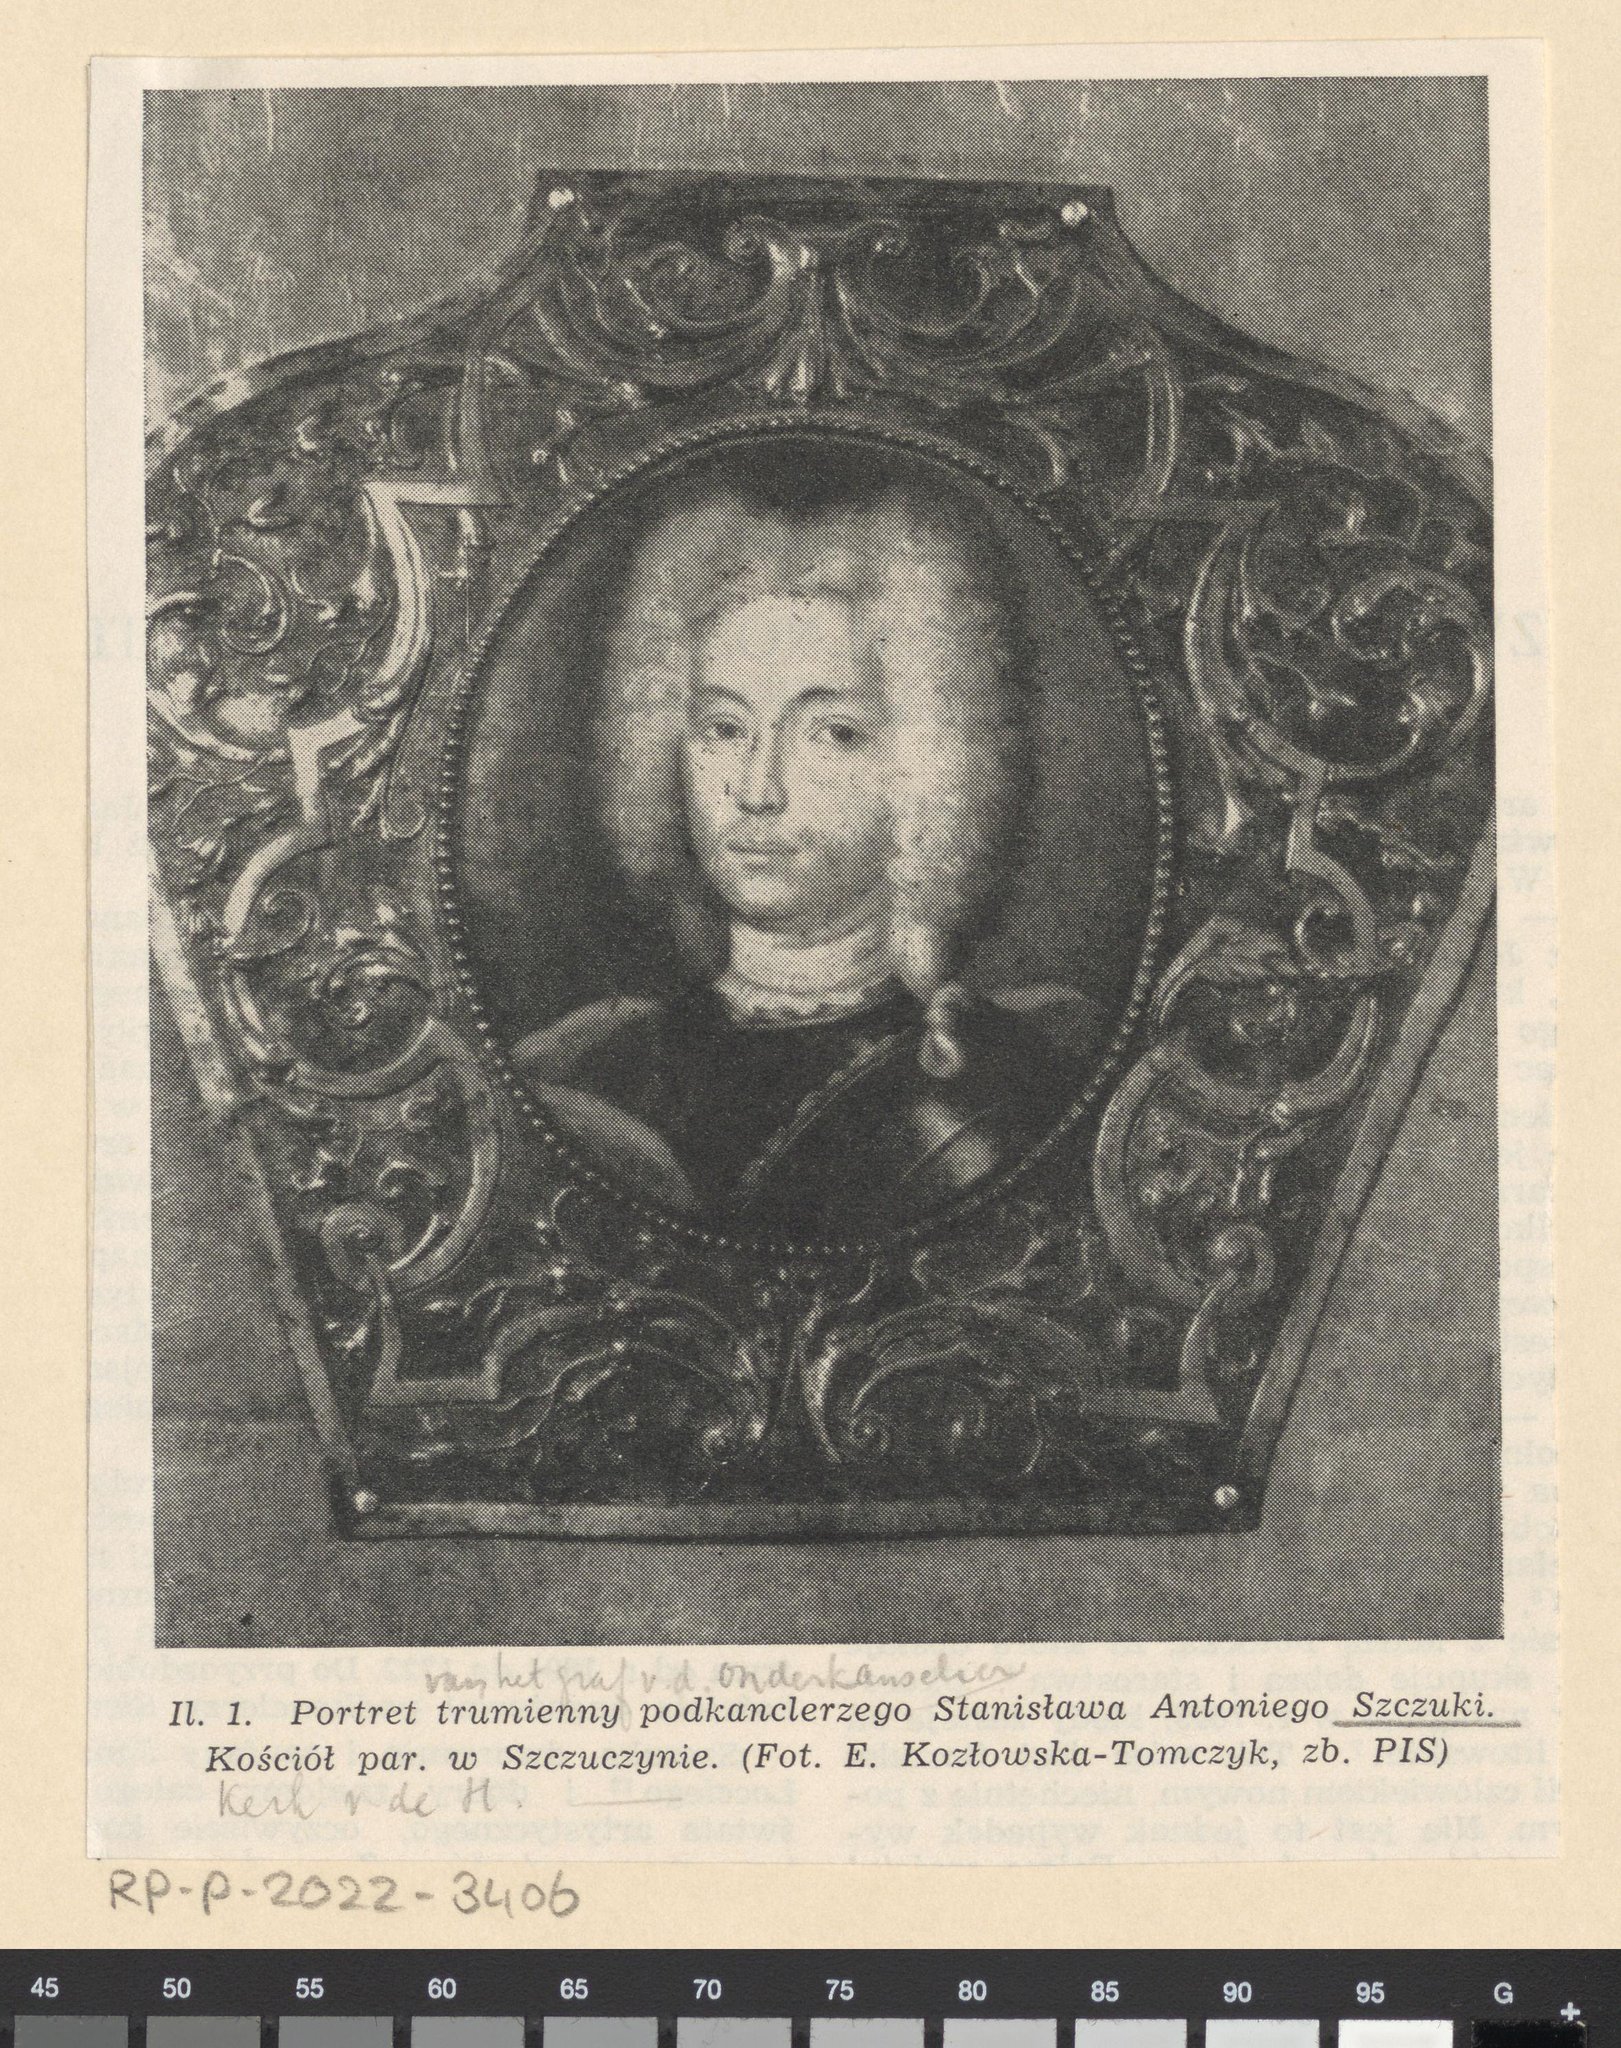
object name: photomechanical print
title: Portret van Stanislaw Antoni Szczuka op zijn graf in de kerk van Szczuczyn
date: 1955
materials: paper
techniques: letterpress printing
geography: poland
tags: politician, historical persons, politician, e.g. party leader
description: Prent mogelijk uit: Biuletyn historii sztuki, Instytut Sztuki PAN (1955) dl. 17.